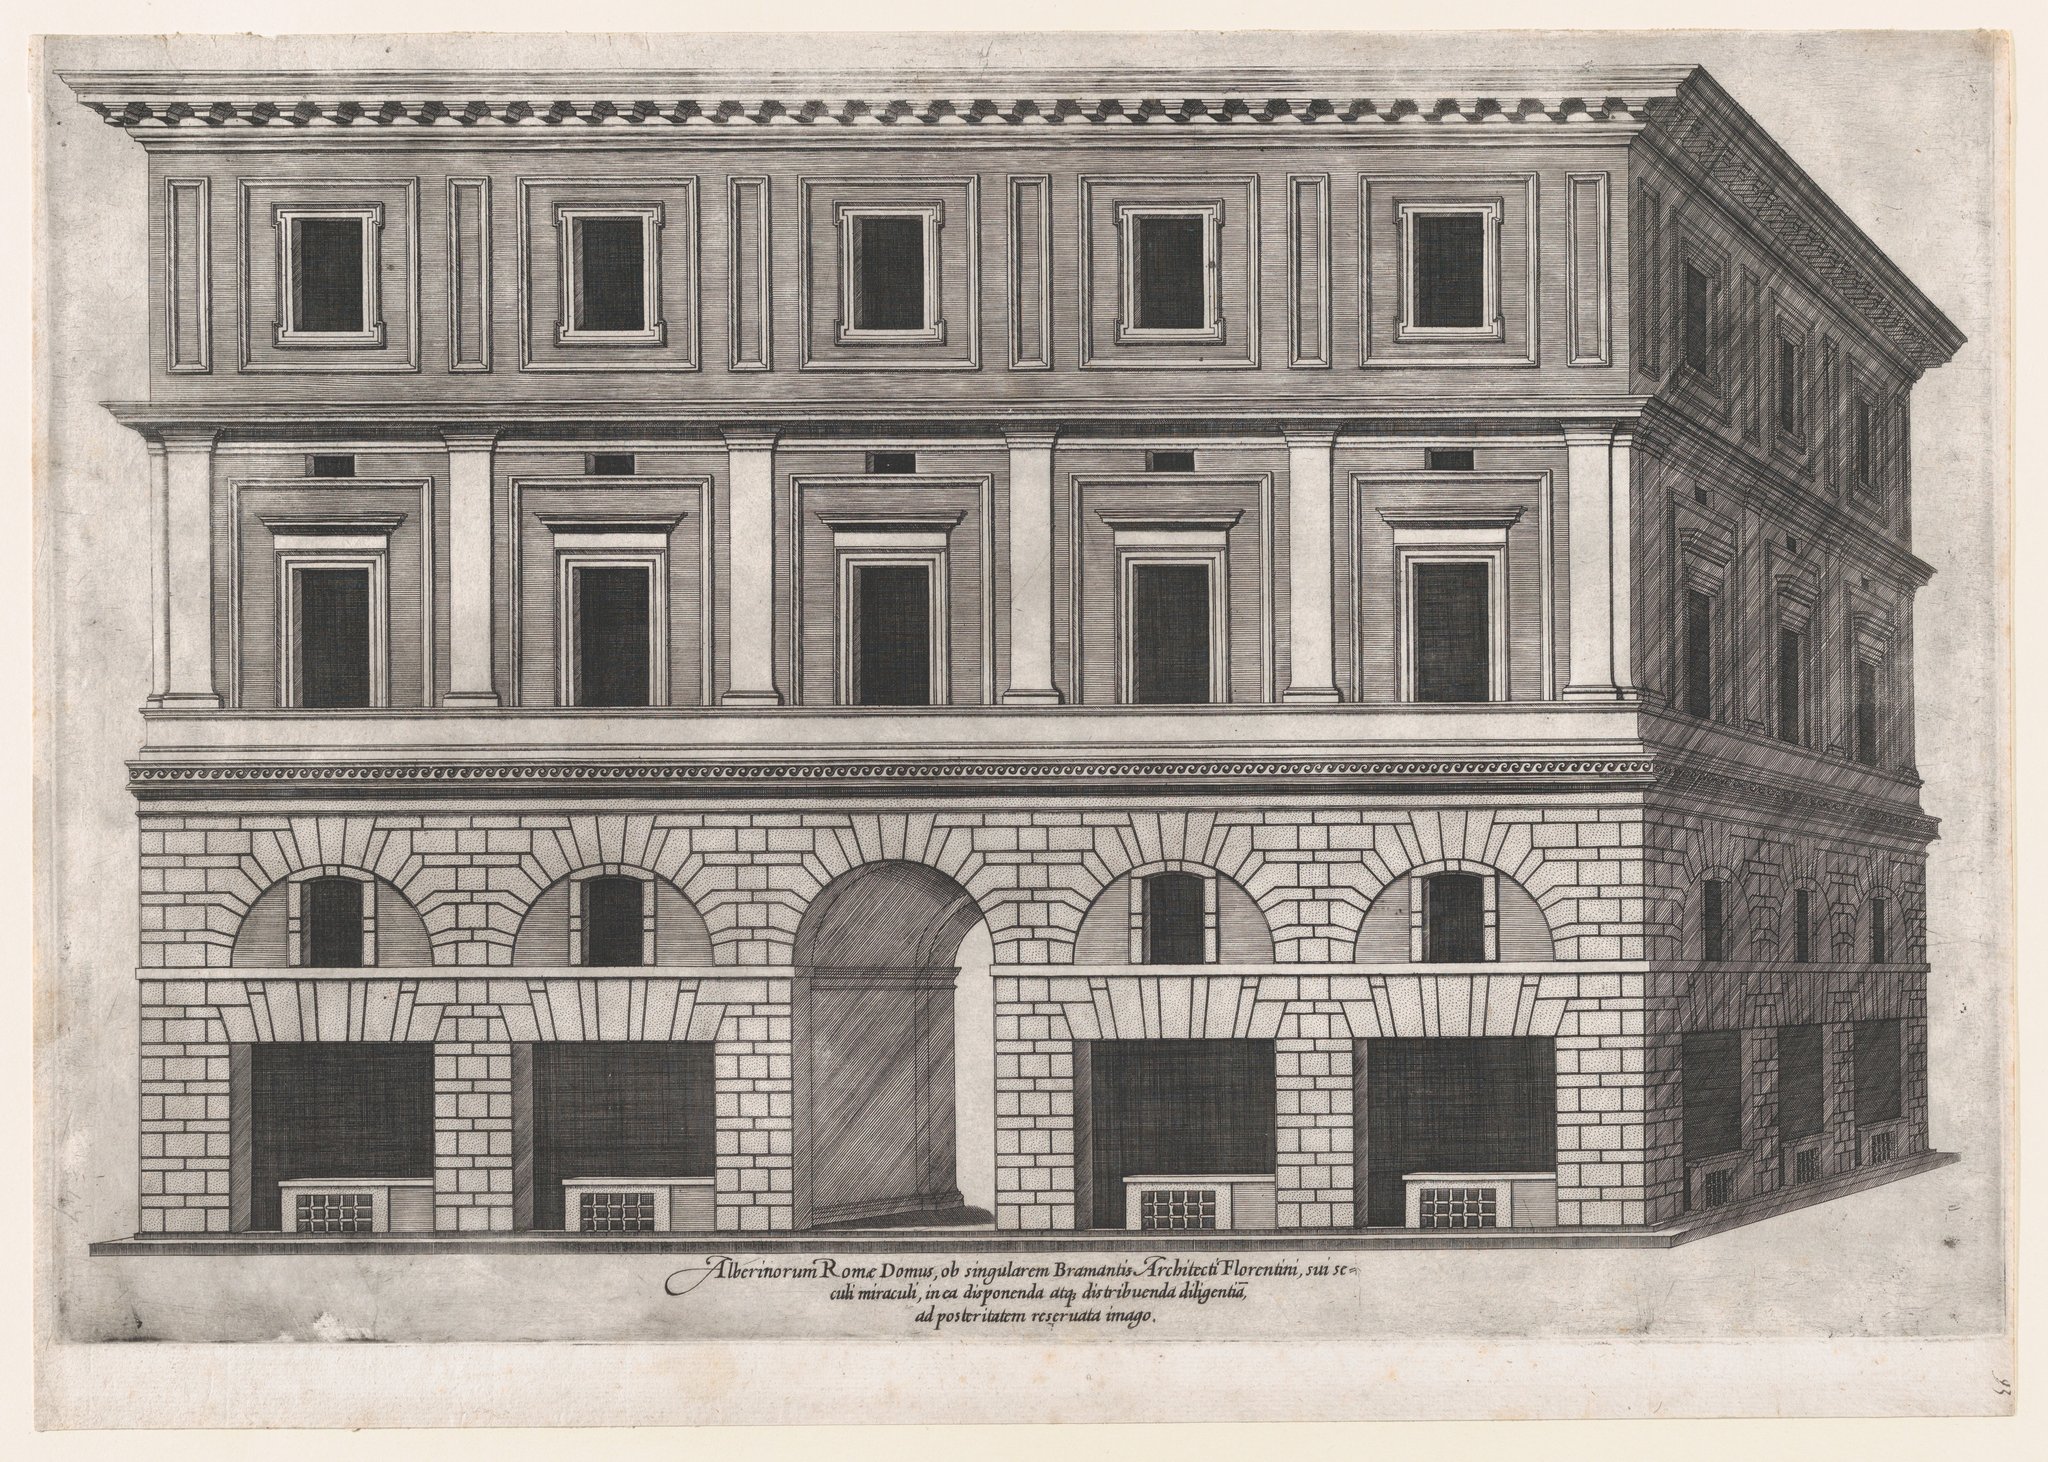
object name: print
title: Alberini Palace, from "Speculum Romanae Magnificentiae"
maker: Anonymous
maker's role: artist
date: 1501-1600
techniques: engraving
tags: architecture,buildings,rome